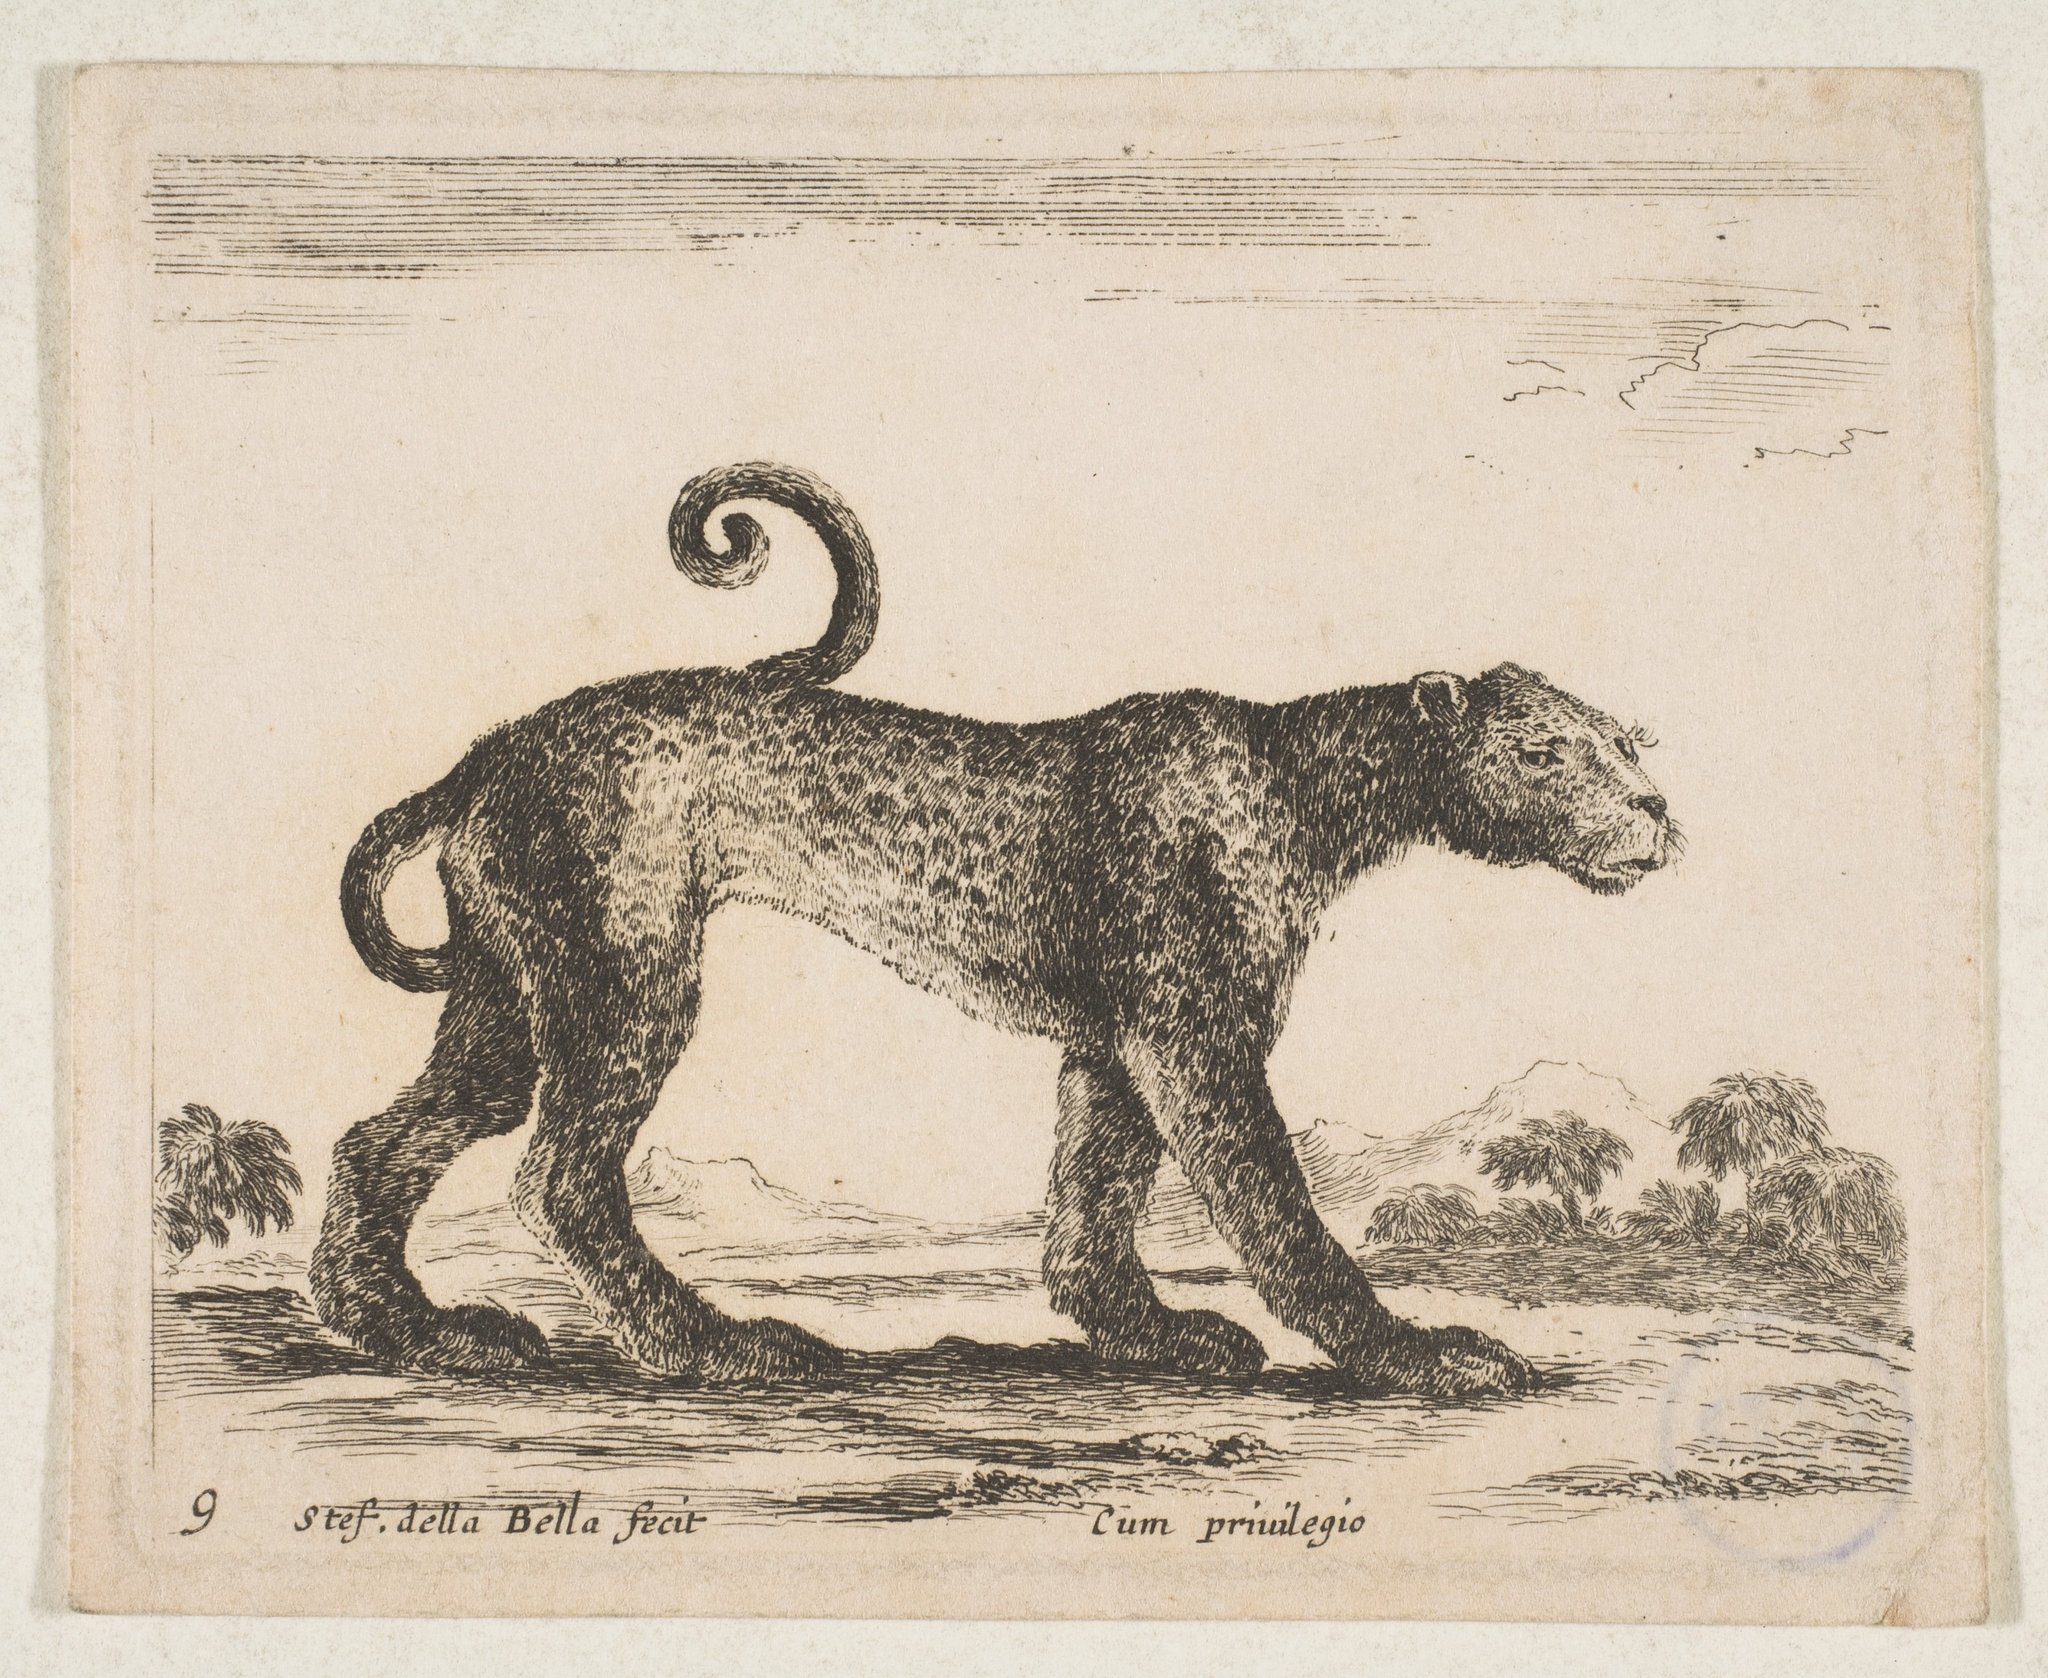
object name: print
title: Plate 9: Leopard, from "Various animals" (Diversi animali)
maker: stefano della bella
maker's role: artist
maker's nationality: italian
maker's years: 1610-1664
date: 1641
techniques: etching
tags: leopards